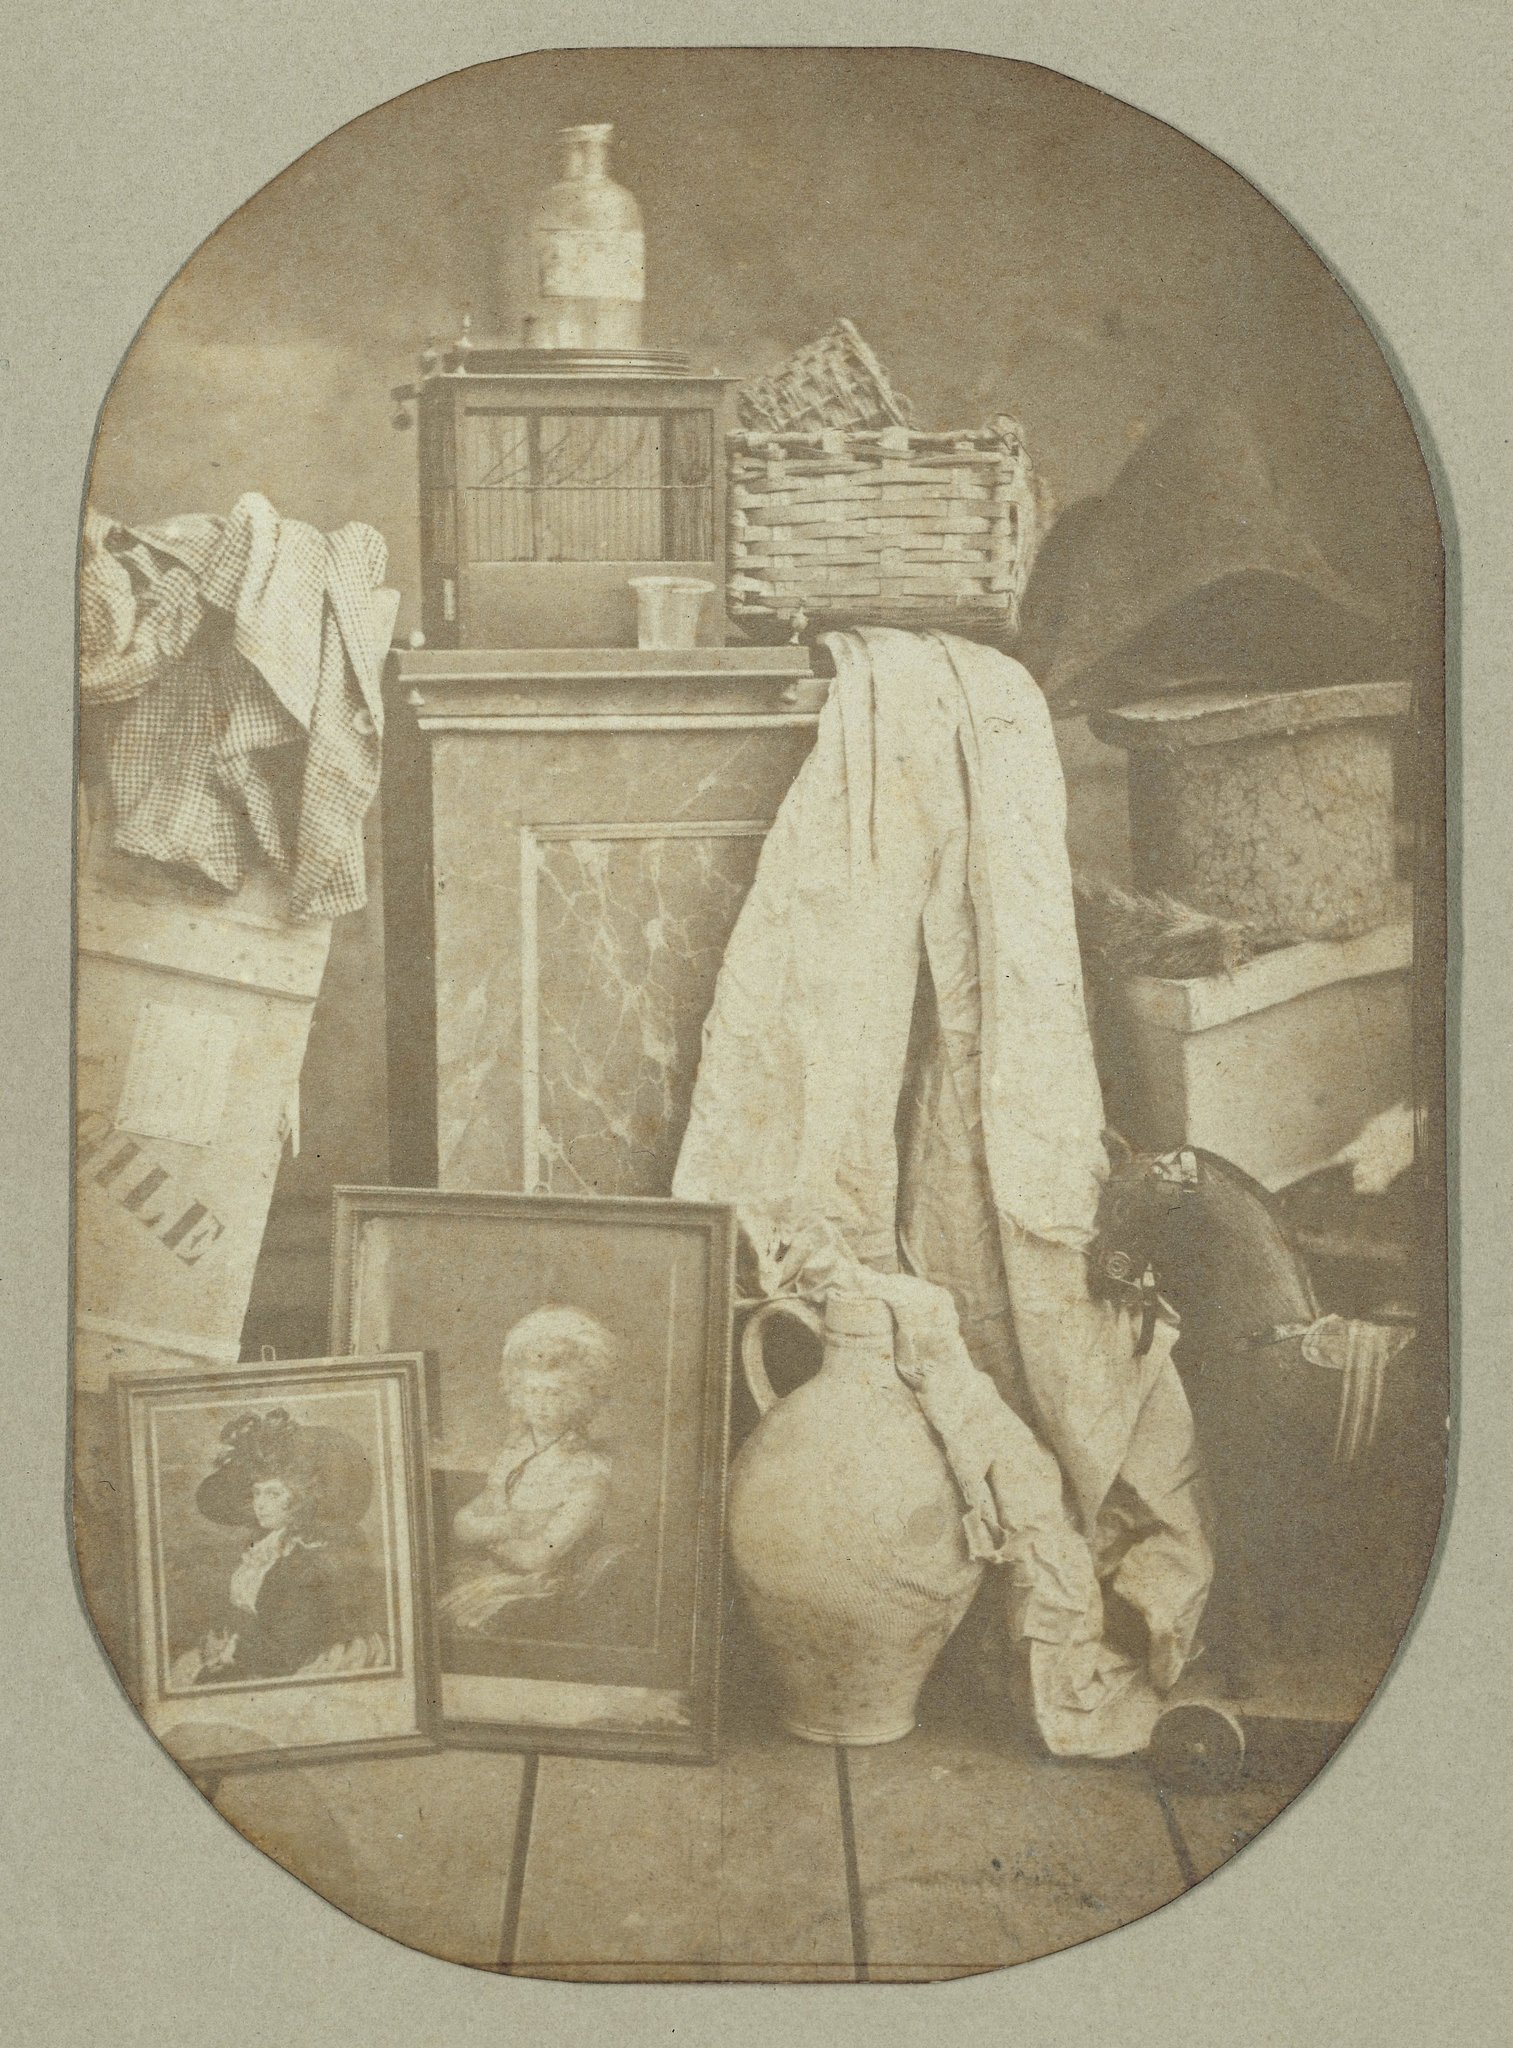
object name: photograph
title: Stilleven met allerlei voorwerpen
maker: eduard isaac asser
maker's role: amateurfotograaf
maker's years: 1809-1894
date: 1855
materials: cardboard, paper, photographic support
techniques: salted paper print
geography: amsterdam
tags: still life of related objects, netherlands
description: schilderijen, kan, speelgoedpaard en andere voorwerpen